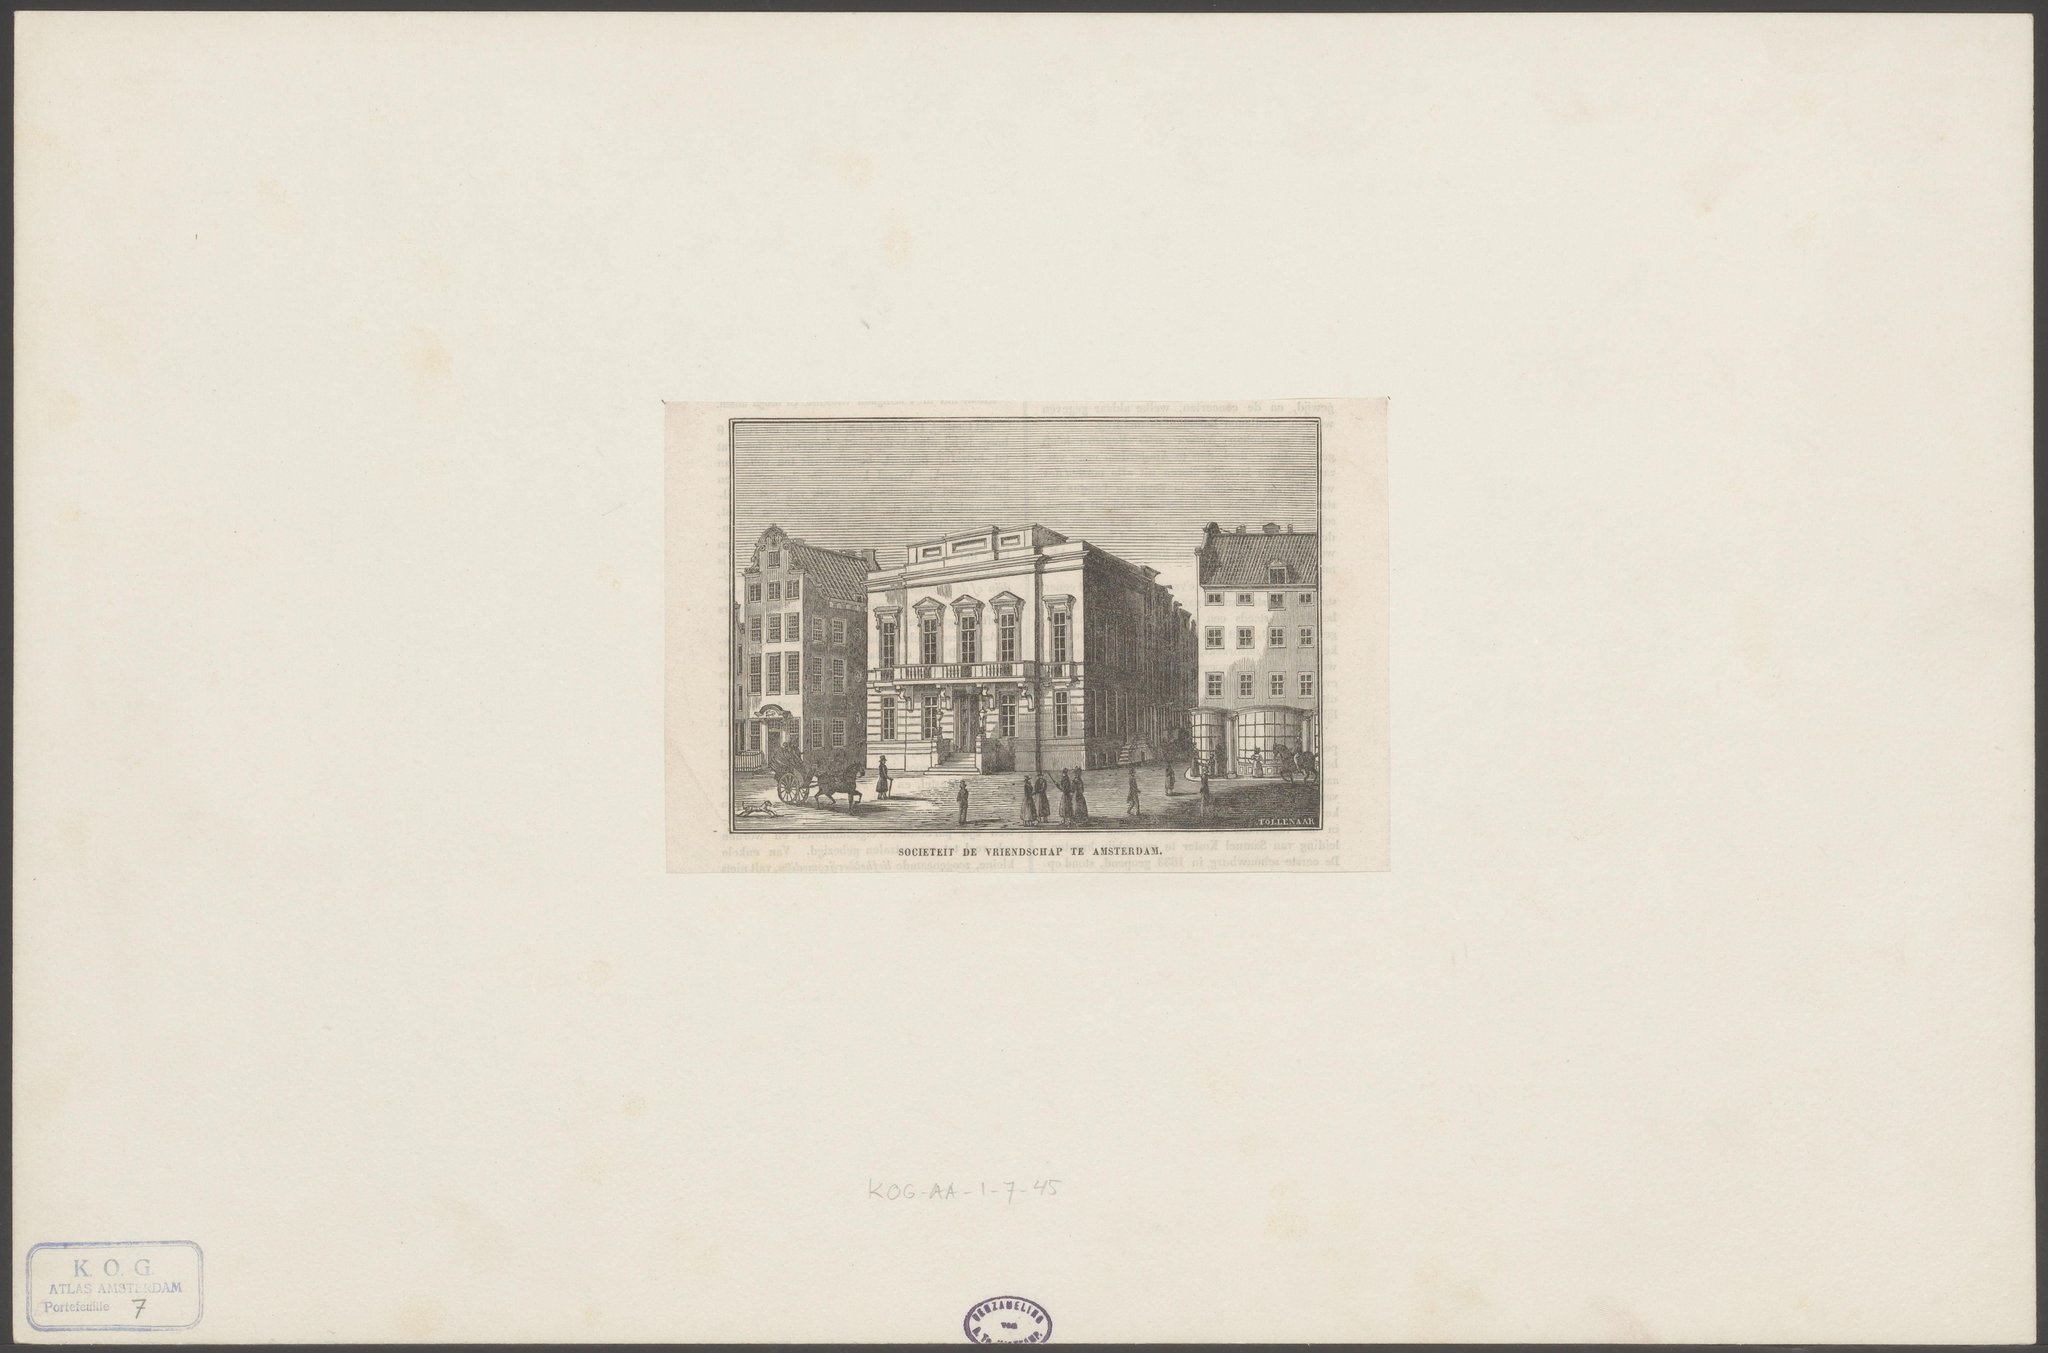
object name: print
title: Societeit de Vriendschap te Amsterdam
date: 1841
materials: paper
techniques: letterpress printing, engraving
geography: amsterdam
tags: square, place, circus, etc., city-view in general; 'veduta', façade (of house or building)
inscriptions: collector's mark: Lugt 1243, signature: ‘Tollenaar’, collector's mark: ‘7’ Lugt 1641b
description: Prent uit: Beschrijving der Nederlanden. Amsterdam: J.H. Laarman, 1841.